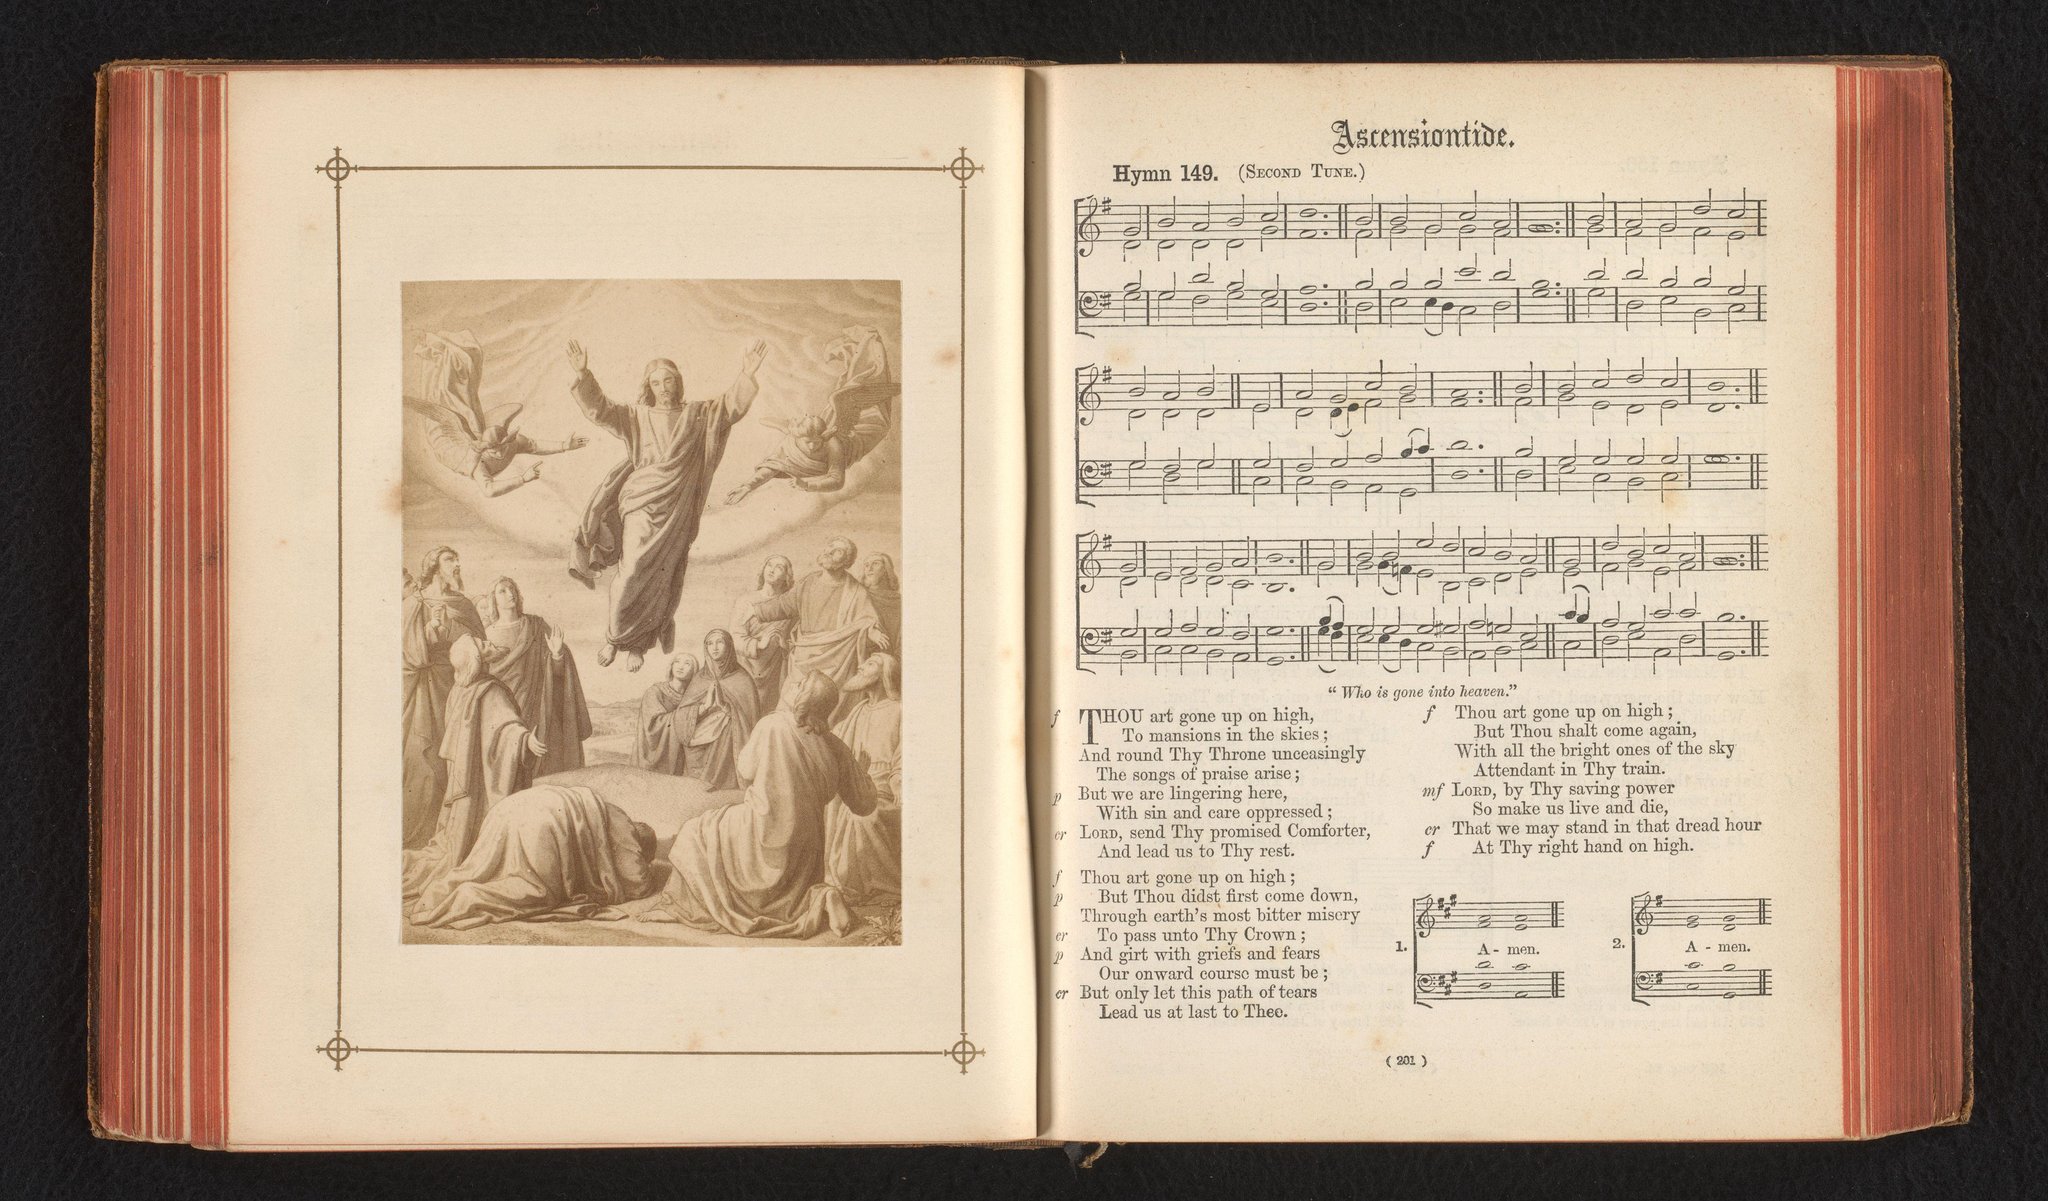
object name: page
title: Fotoreproductie van een schilderij van de hemelvaart van Christus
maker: Anonymous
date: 1866-1876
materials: paper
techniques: albumen print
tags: the ascension (christ surrounded by radiant light or in a mandorla), picture, painting